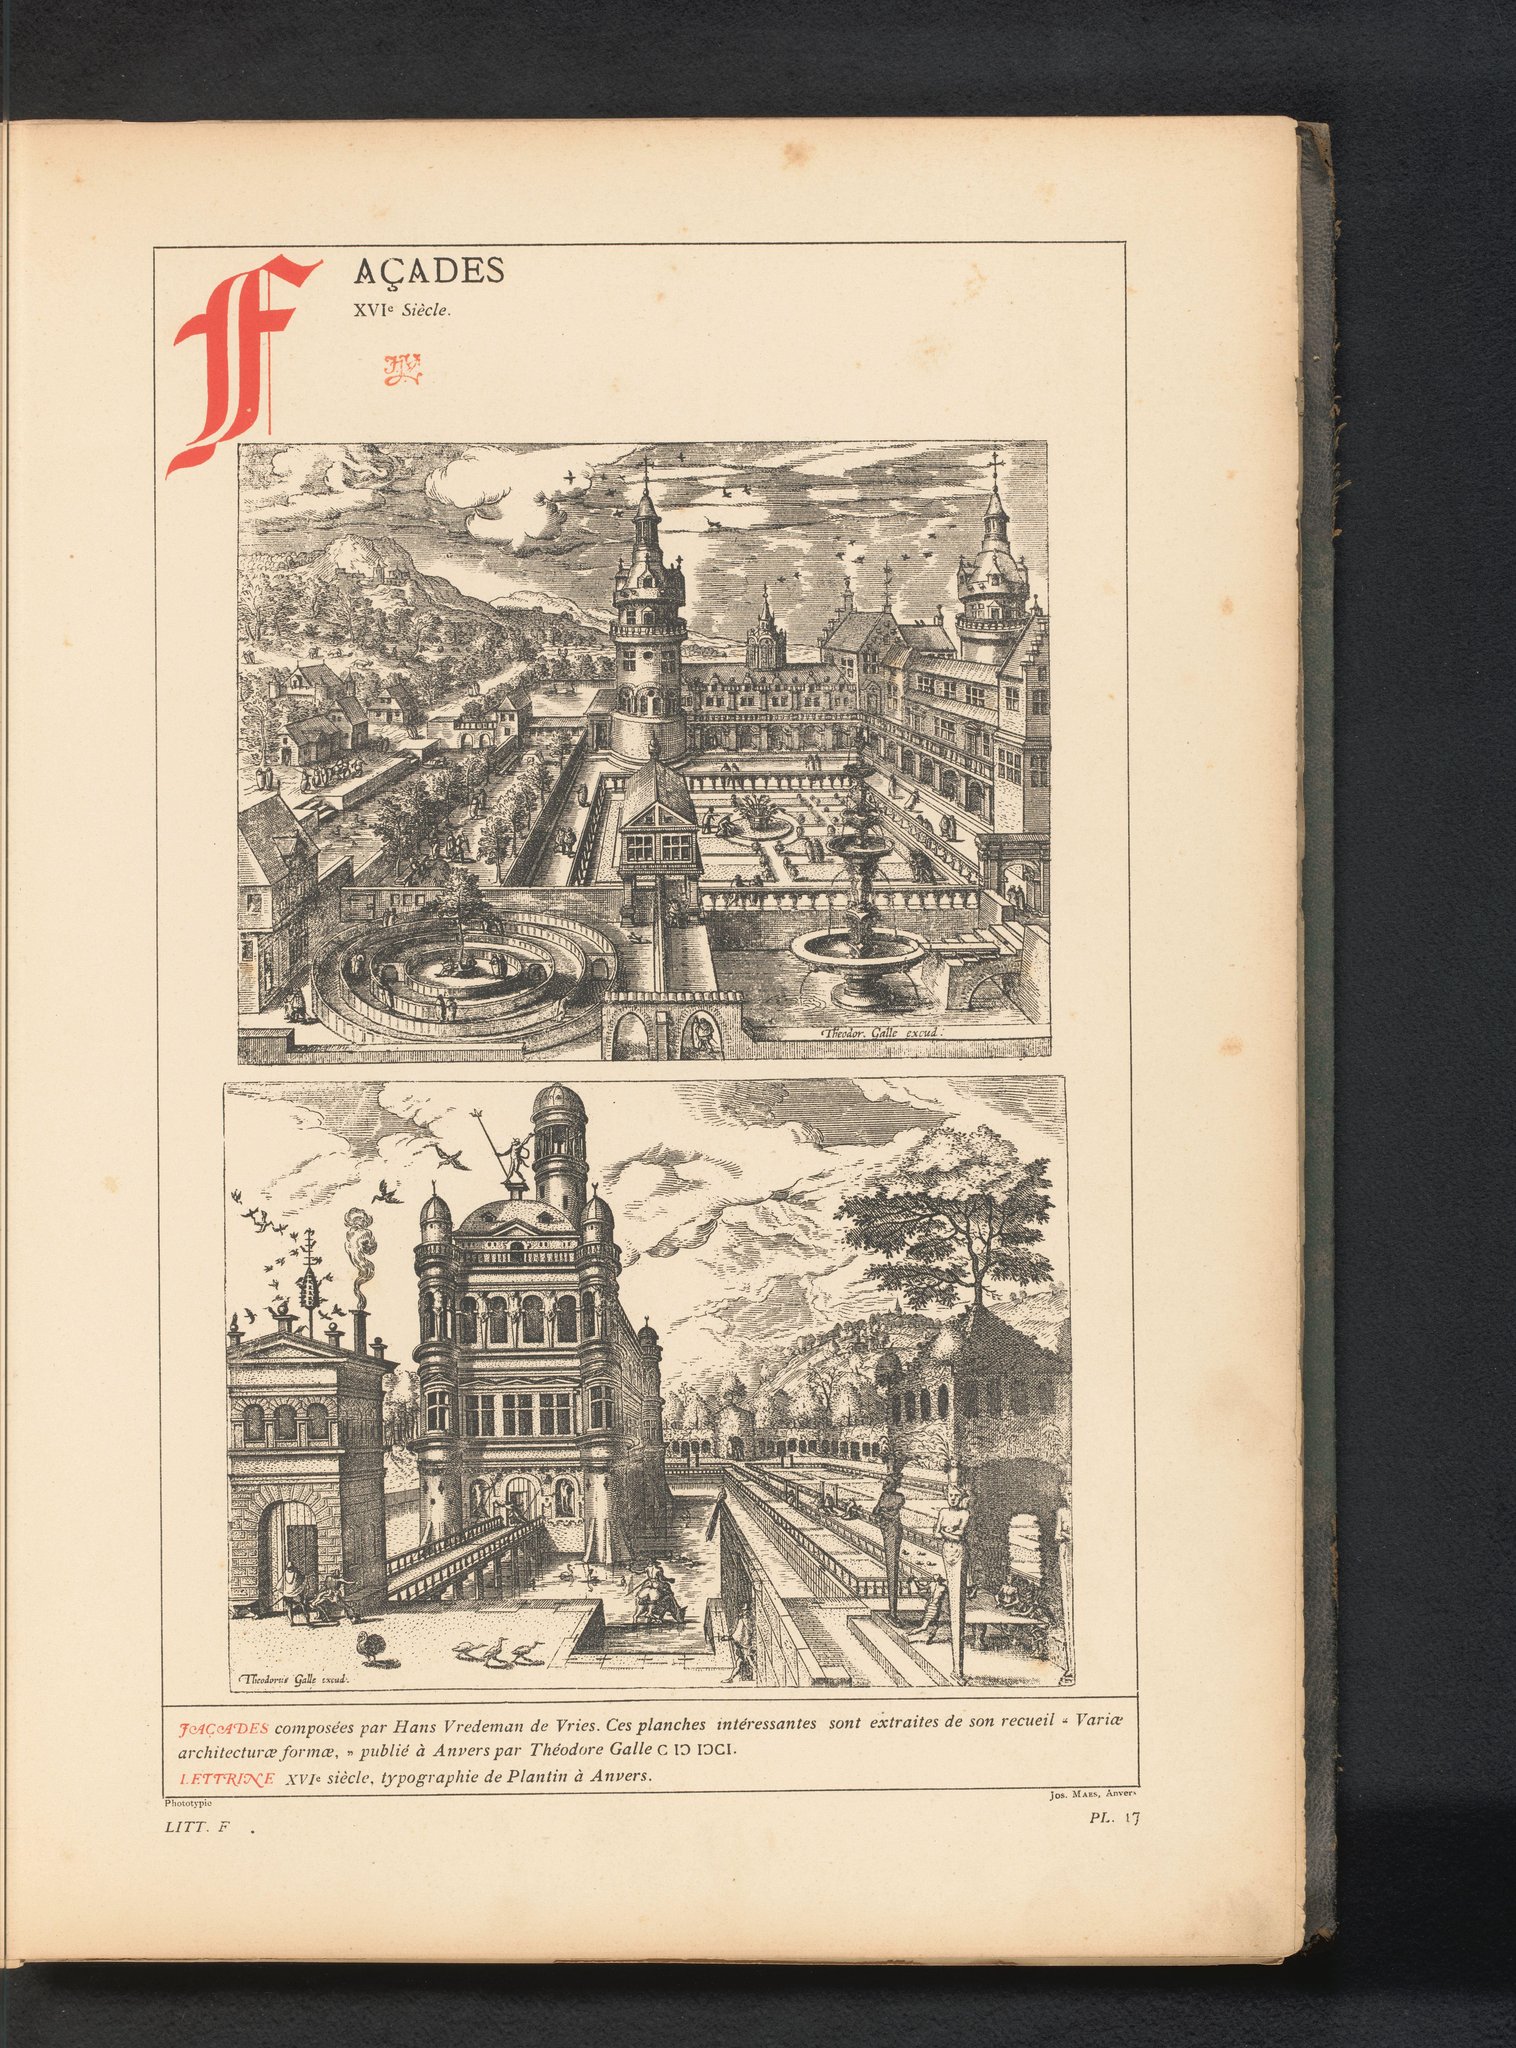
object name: reproduction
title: Façades, XVIe Siècle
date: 1875-1880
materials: paper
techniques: photolithography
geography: antwerp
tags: villa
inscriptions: monogram: ‘JJvY’, inscription: ‘LITT. F. - PL. 17’, inscription: ‘FAÇADES composées par (...)’